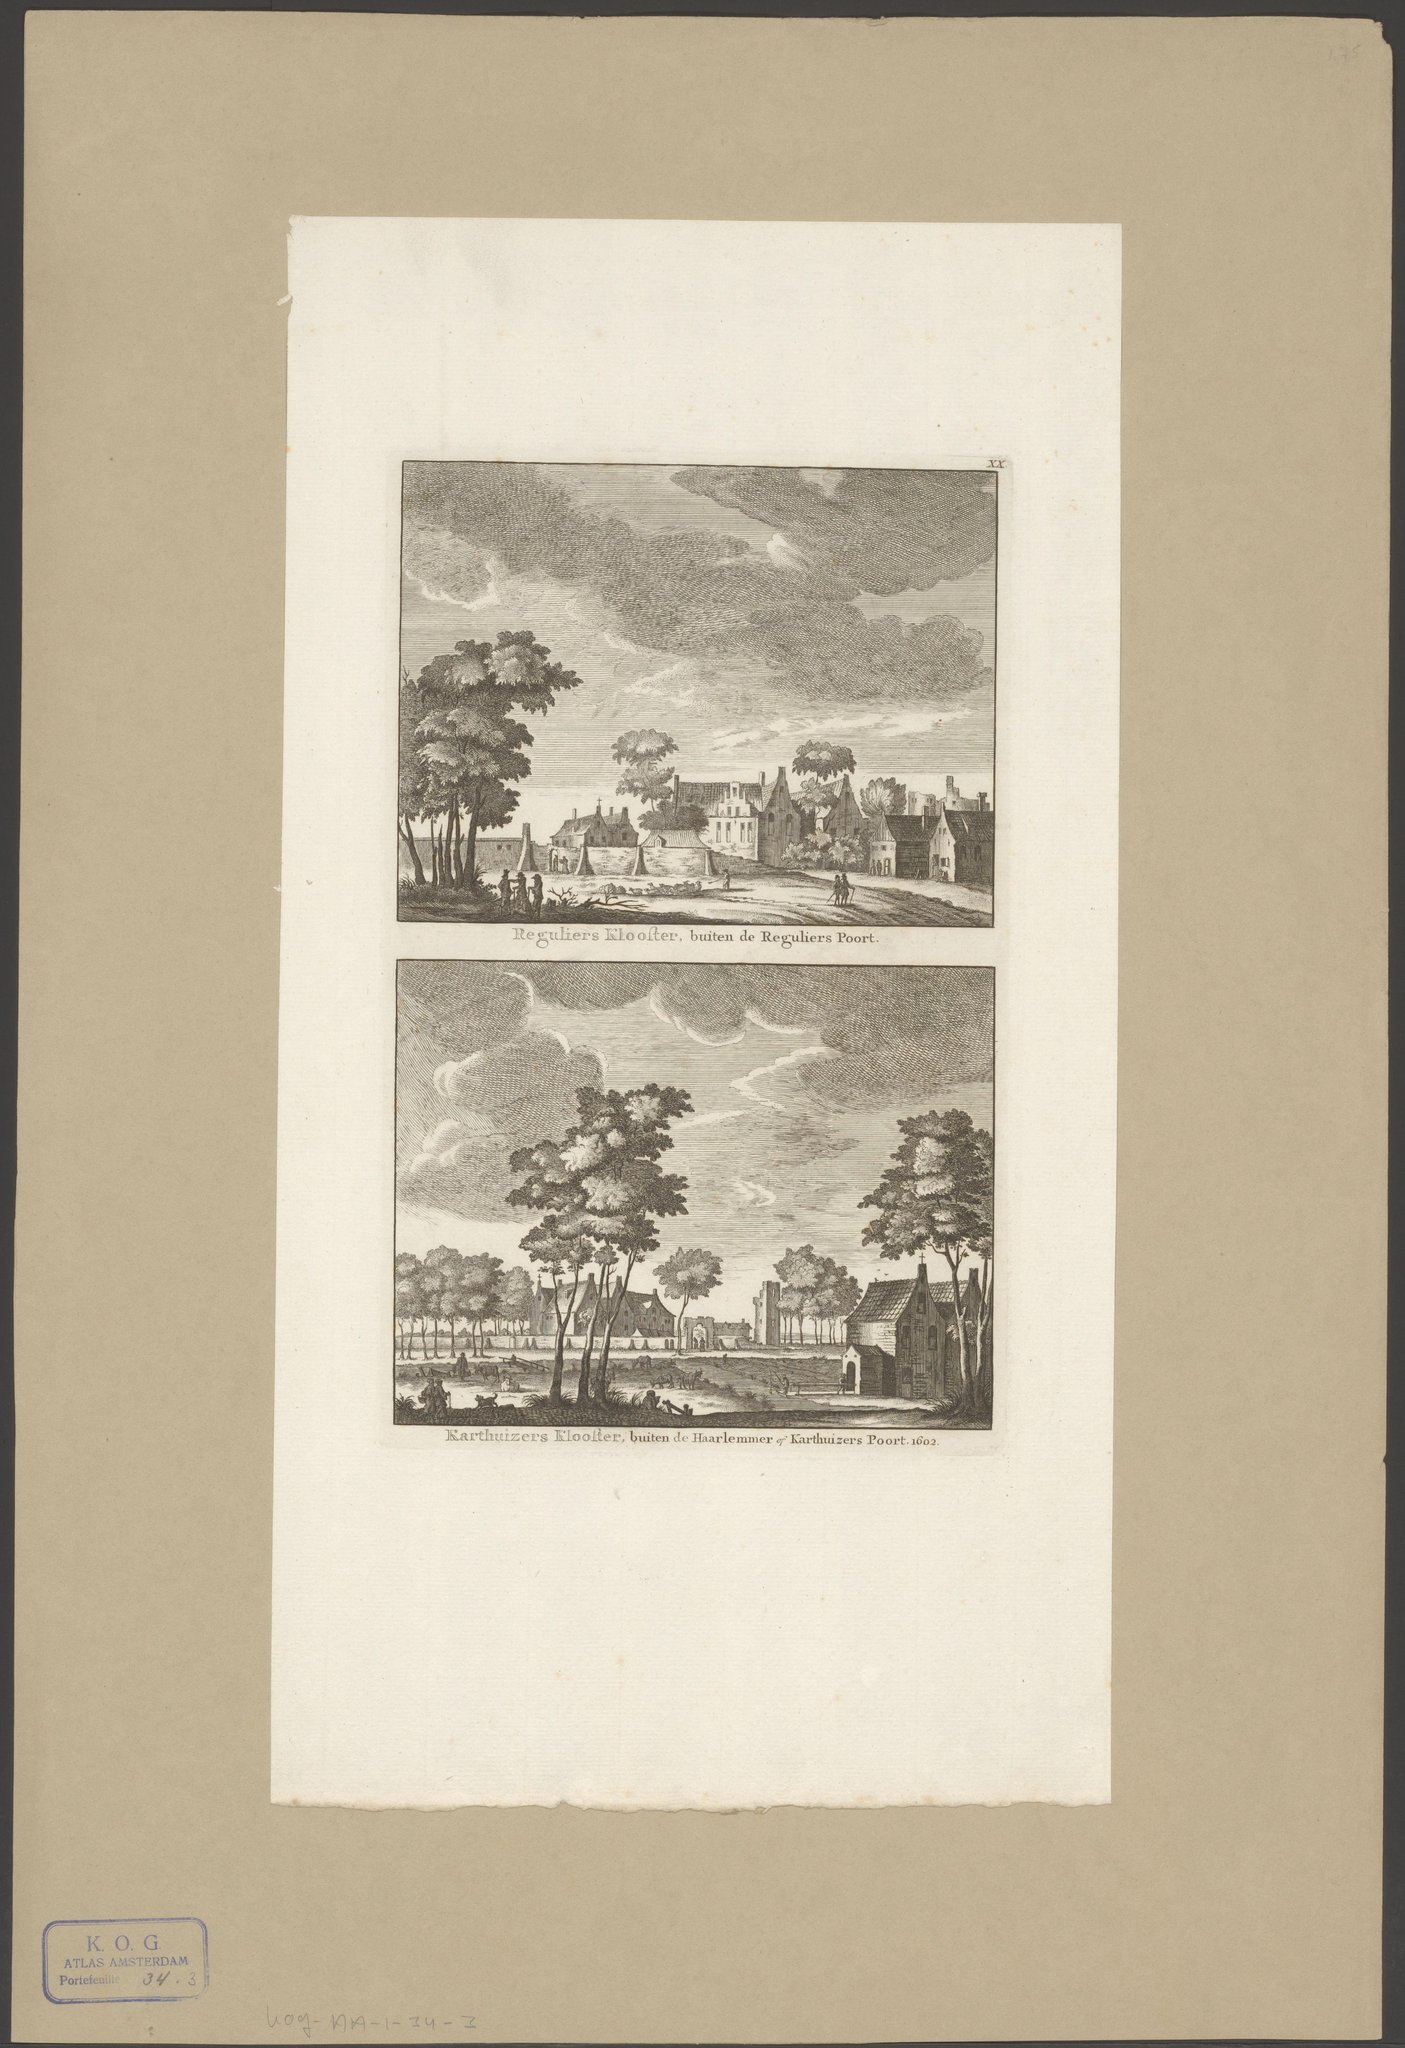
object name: print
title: Gezicht op het Reguliersklooster en het Kartuizerklooster buiten Amsterdam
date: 1760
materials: paper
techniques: engraving, etching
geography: amsterdam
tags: monastic orders, monastic life: carthusians, abbey, monastery, convent ~ roman catholic church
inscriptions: collector's mark: Lugt 1641b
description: Prent mogelijk uit: Wagenaar, Jan. Amsterdam, in zyne opkomst, aanwas, geschiedenissen (…). Amsterdam: Isaak Tirion, 1760, dl. 1.